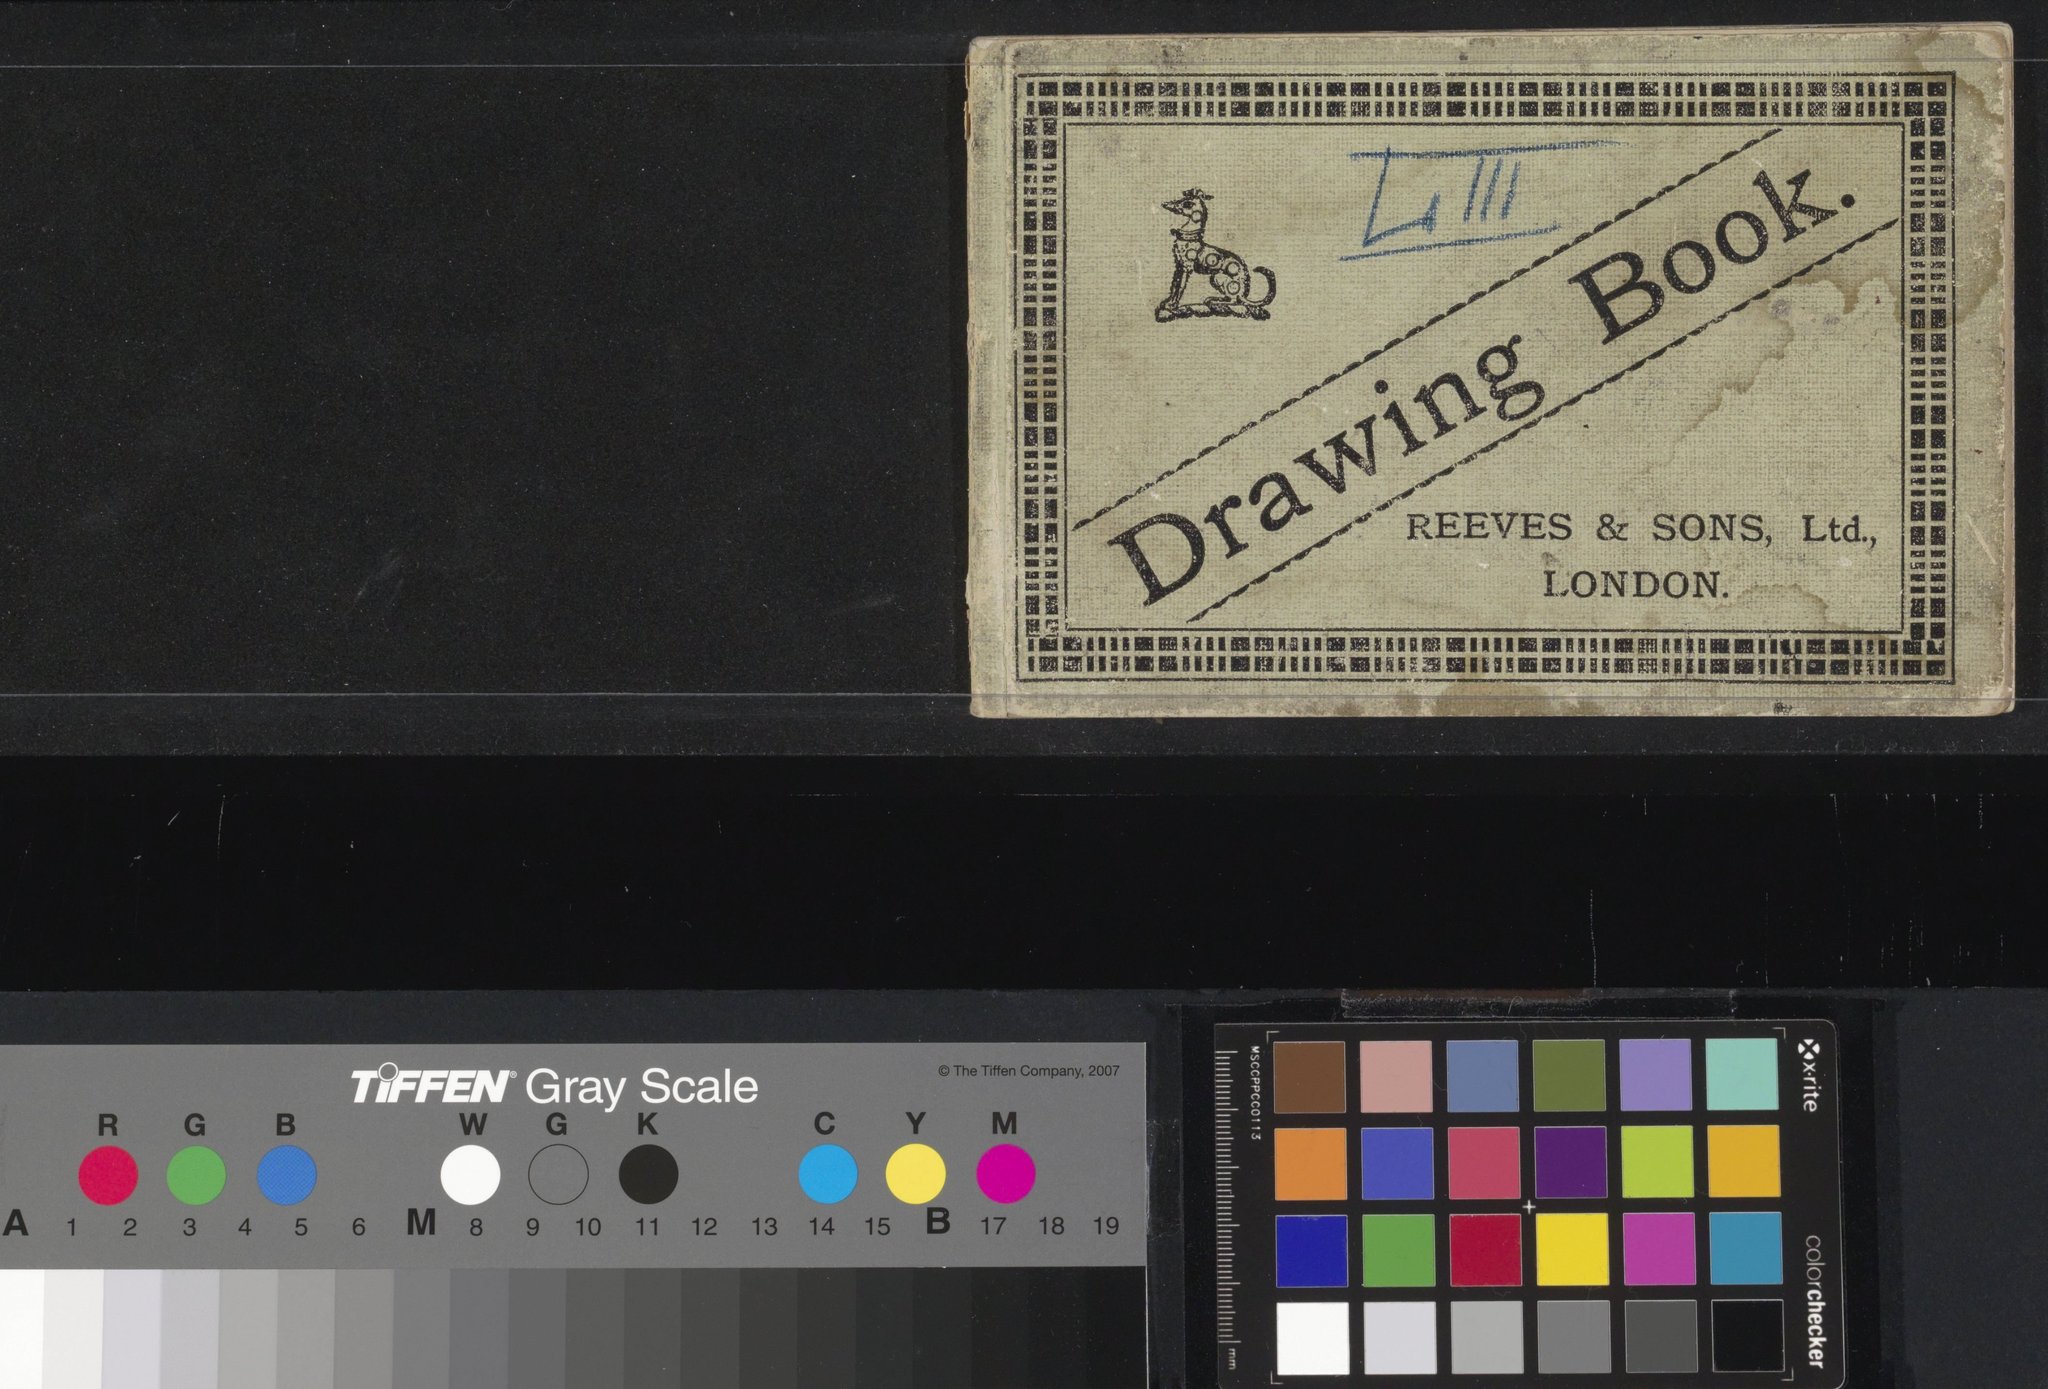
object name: sketchbook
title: Schetsboek LIII met 10 bladen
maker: isaac israels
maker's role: draughtsman, painter, print maker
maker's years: 1865-1934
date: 1875-1934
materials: cardboard, chalk, linen, paper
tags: maid ~ house personnel, street (+ city(-scape) with figures, staffage)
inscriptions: inscription: ‘Drawing Book. / Reeves & Sons, Ltd., / London / Reeves & Sons, Limited. / oil colours / [...]/ water colours / for Artists and Students.’, collector's mark: Lugt 2228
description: Schetsboek nr. LIII bestaande uit 10 bladen met dienstmeiden en een straatgezicht bij nacht.